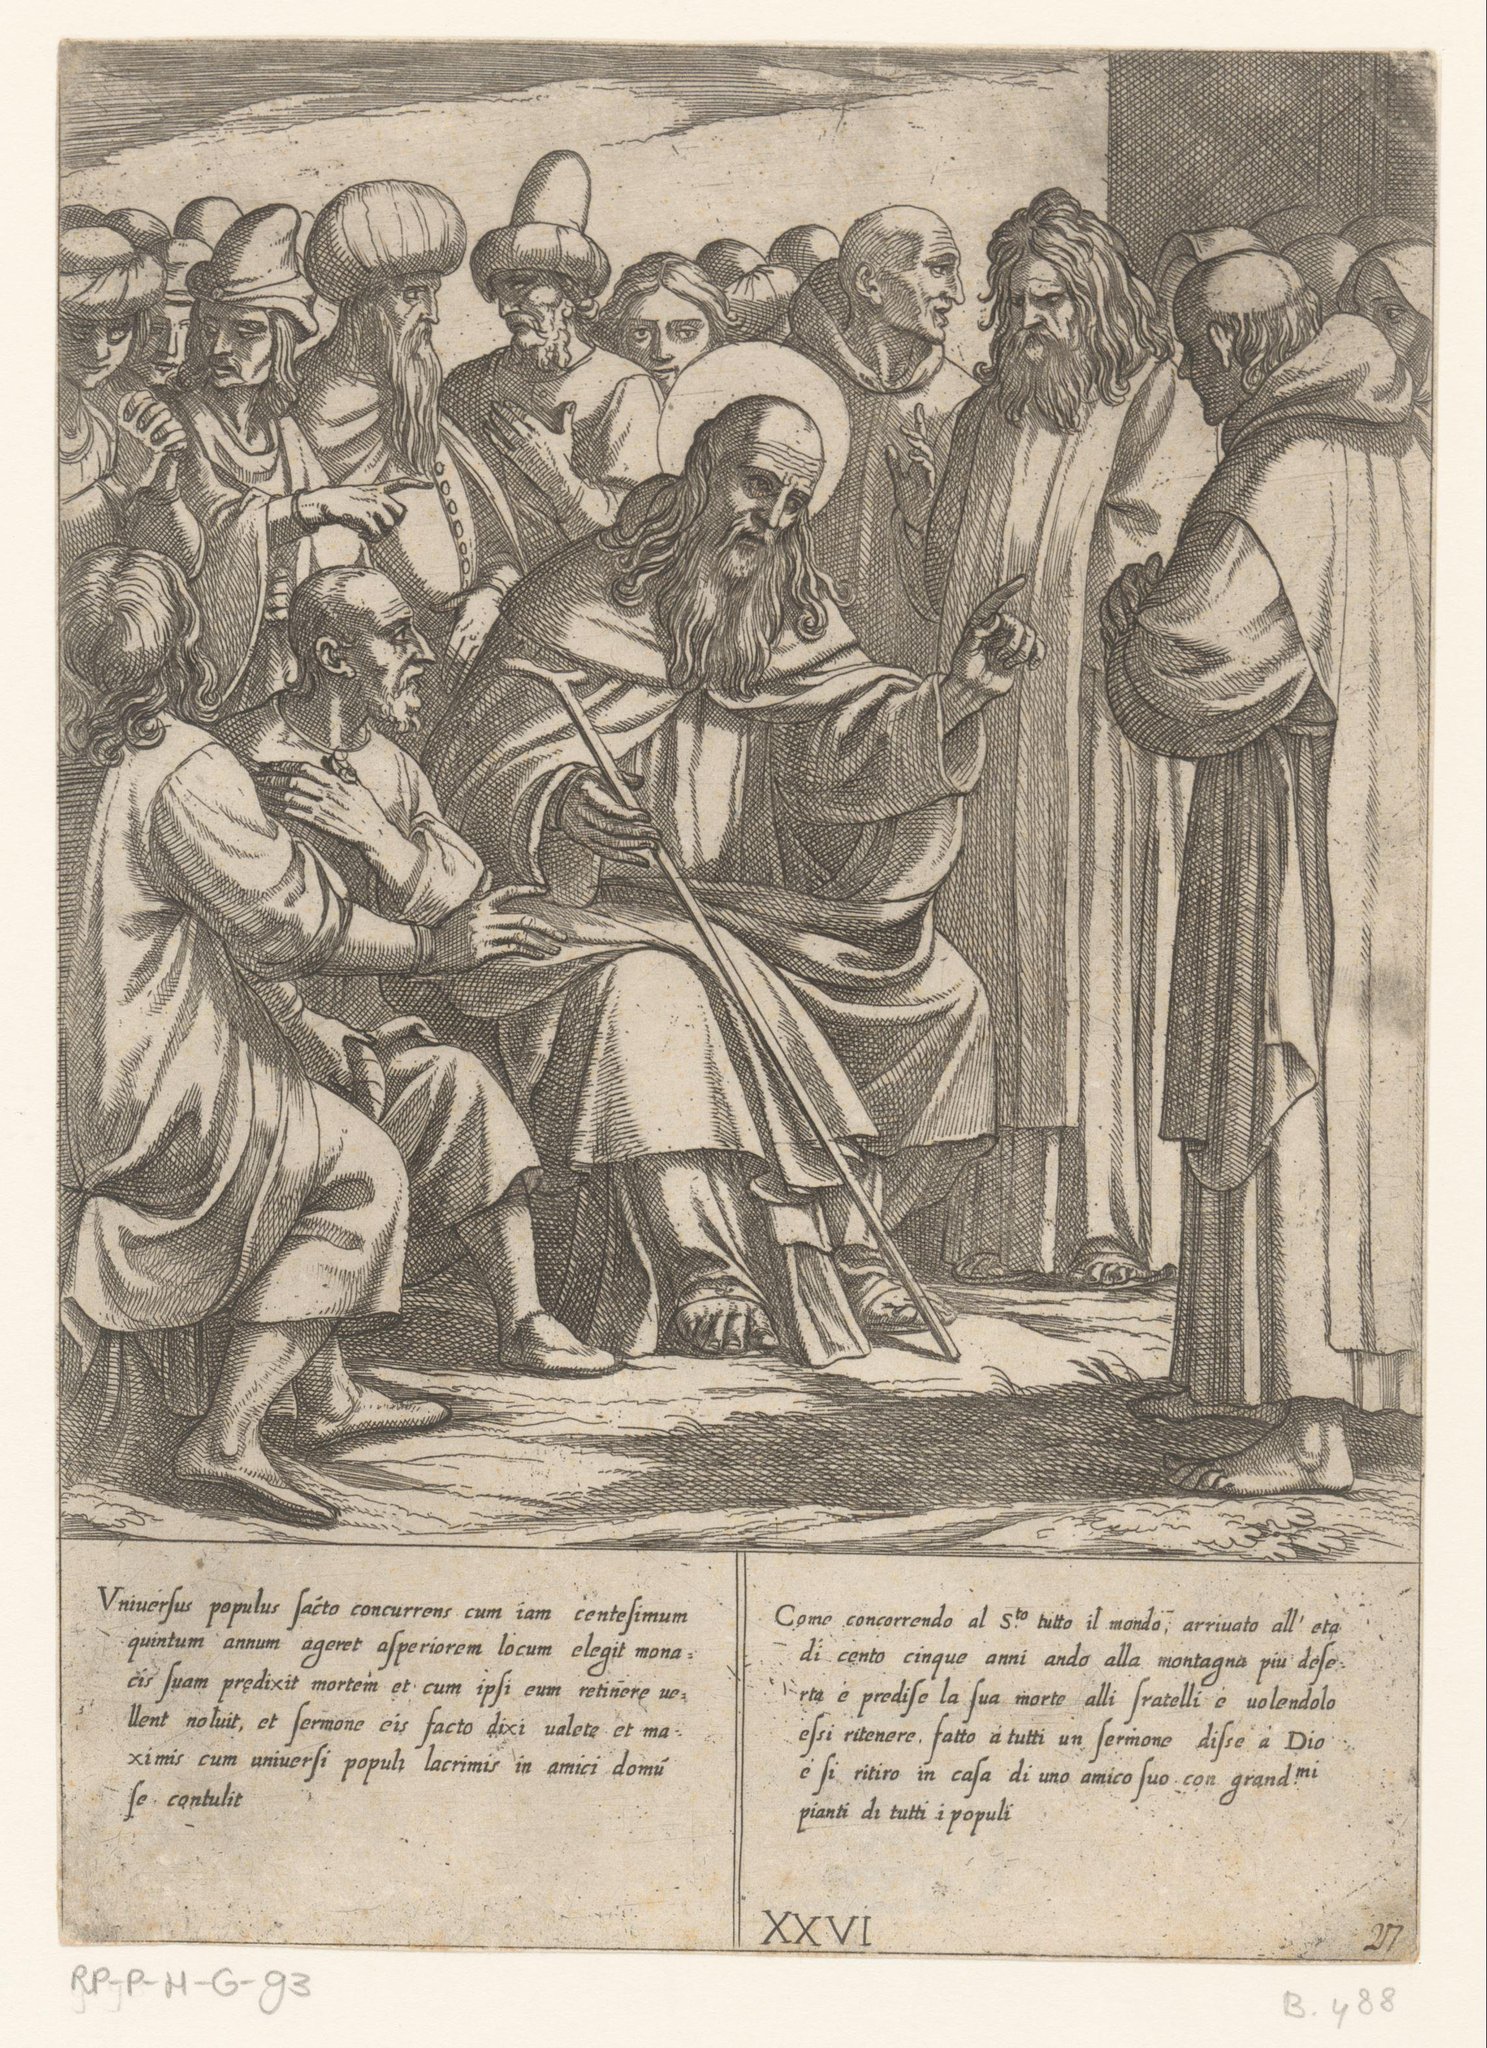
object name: print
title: H. Antonius voorspelt zijn eigen dood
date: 1598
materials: paper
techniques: etching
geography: rome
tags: the hermit antony abbot (antonius abbas) of egypt, also called the great; possible attributes: bell, book, t-shaped staff, flames, pig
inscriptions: collector's mark: Lugt 11, number: ‘27’, collector's mark: ‘Hinloopen’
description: Deze prent maakt deel uit van een reeks van 27 prenten (+ titelprent) over het leven van de heilige Antonius, naar een frescocyclus in de S. Antonio Abbate in Rome door Giovanni Battista Lombardelli en Niccolò Circignani.